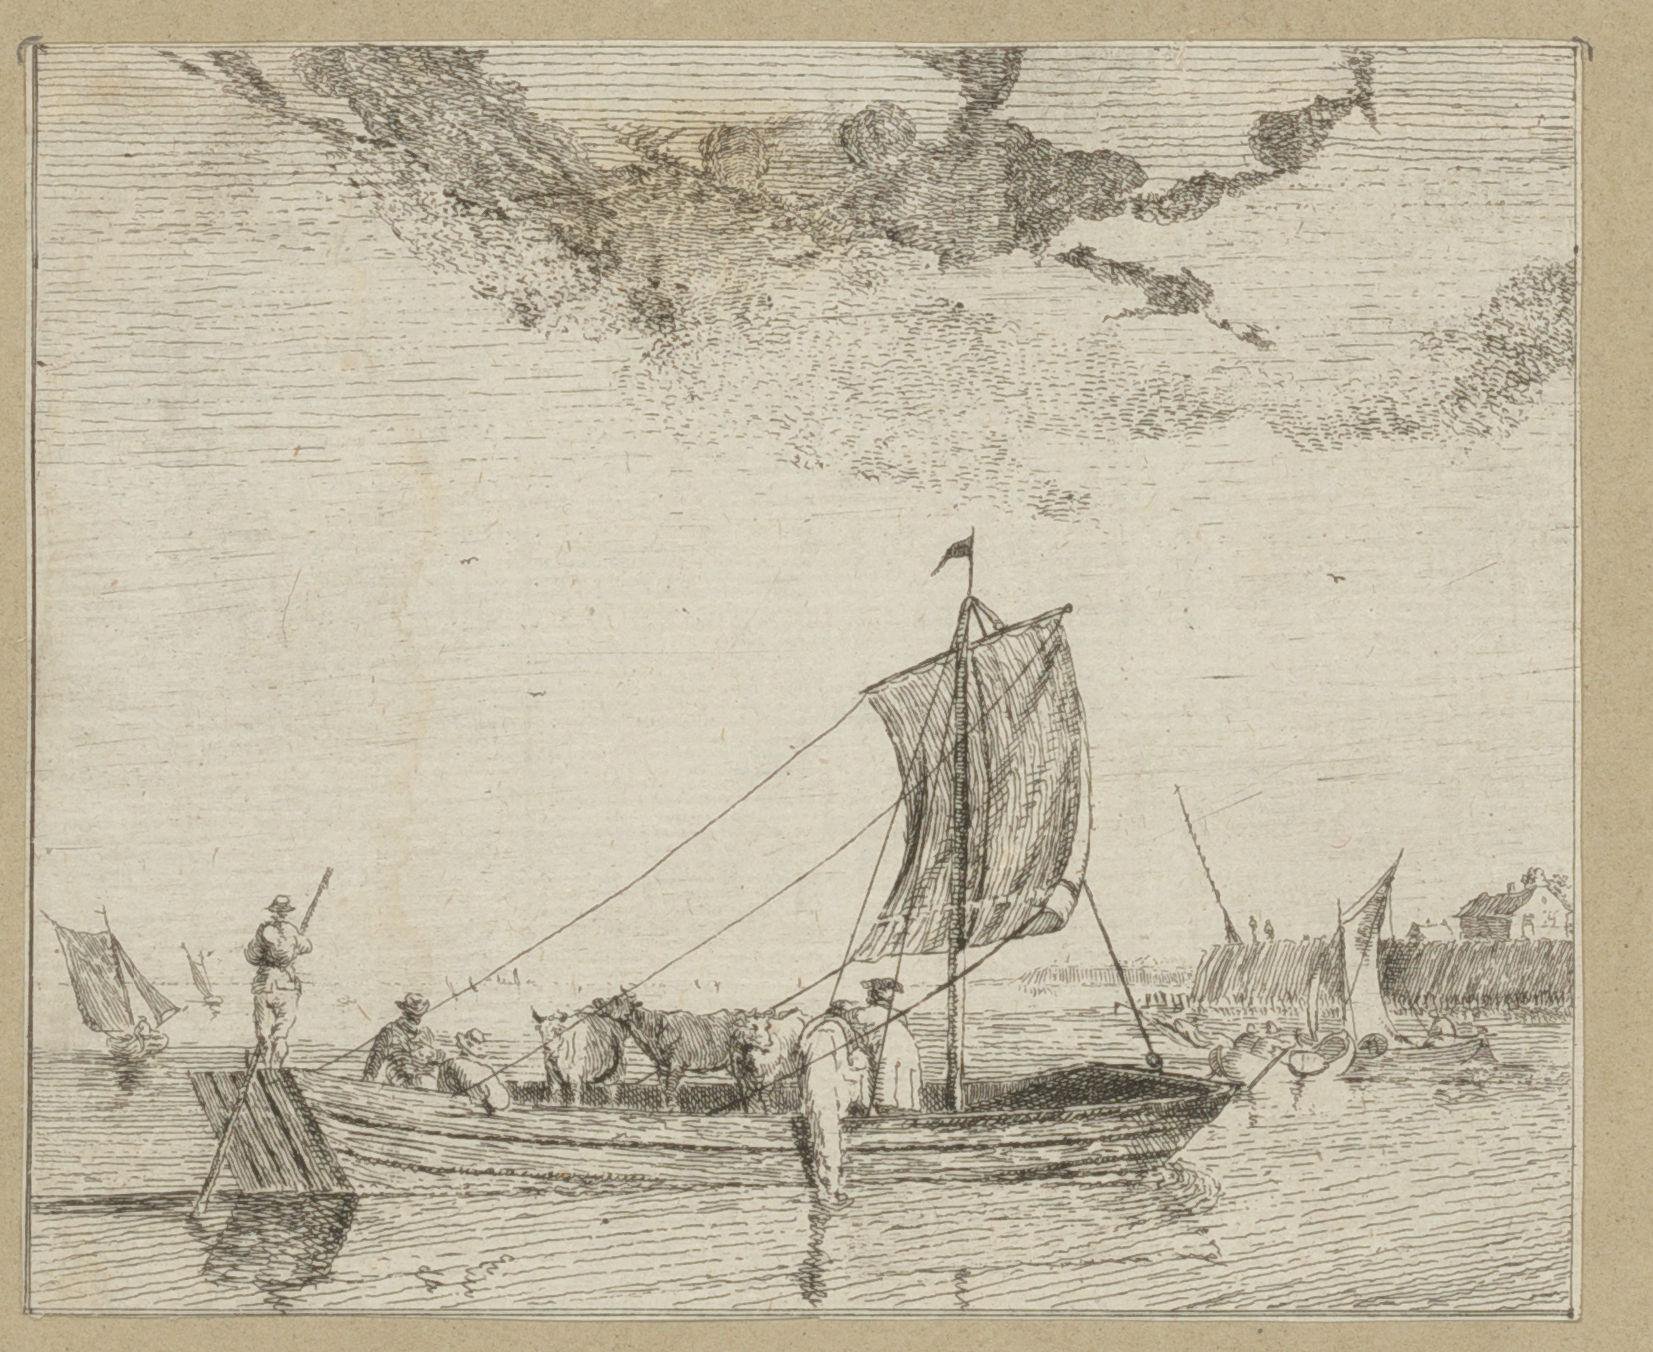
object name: print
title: Vee wordt overgezet met een zeilboot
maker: Anonymous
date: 1650-1749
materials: paper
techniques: etching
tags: sailing-ship, sailing-boat, cattle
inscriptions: collector's mark: Lugt 1641, stamp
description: Onderwerpsrubrieken binnen de Atlas Zeden en Gewoonten: Handel, Nijverheid en Verkeer, Scheepsvaart.